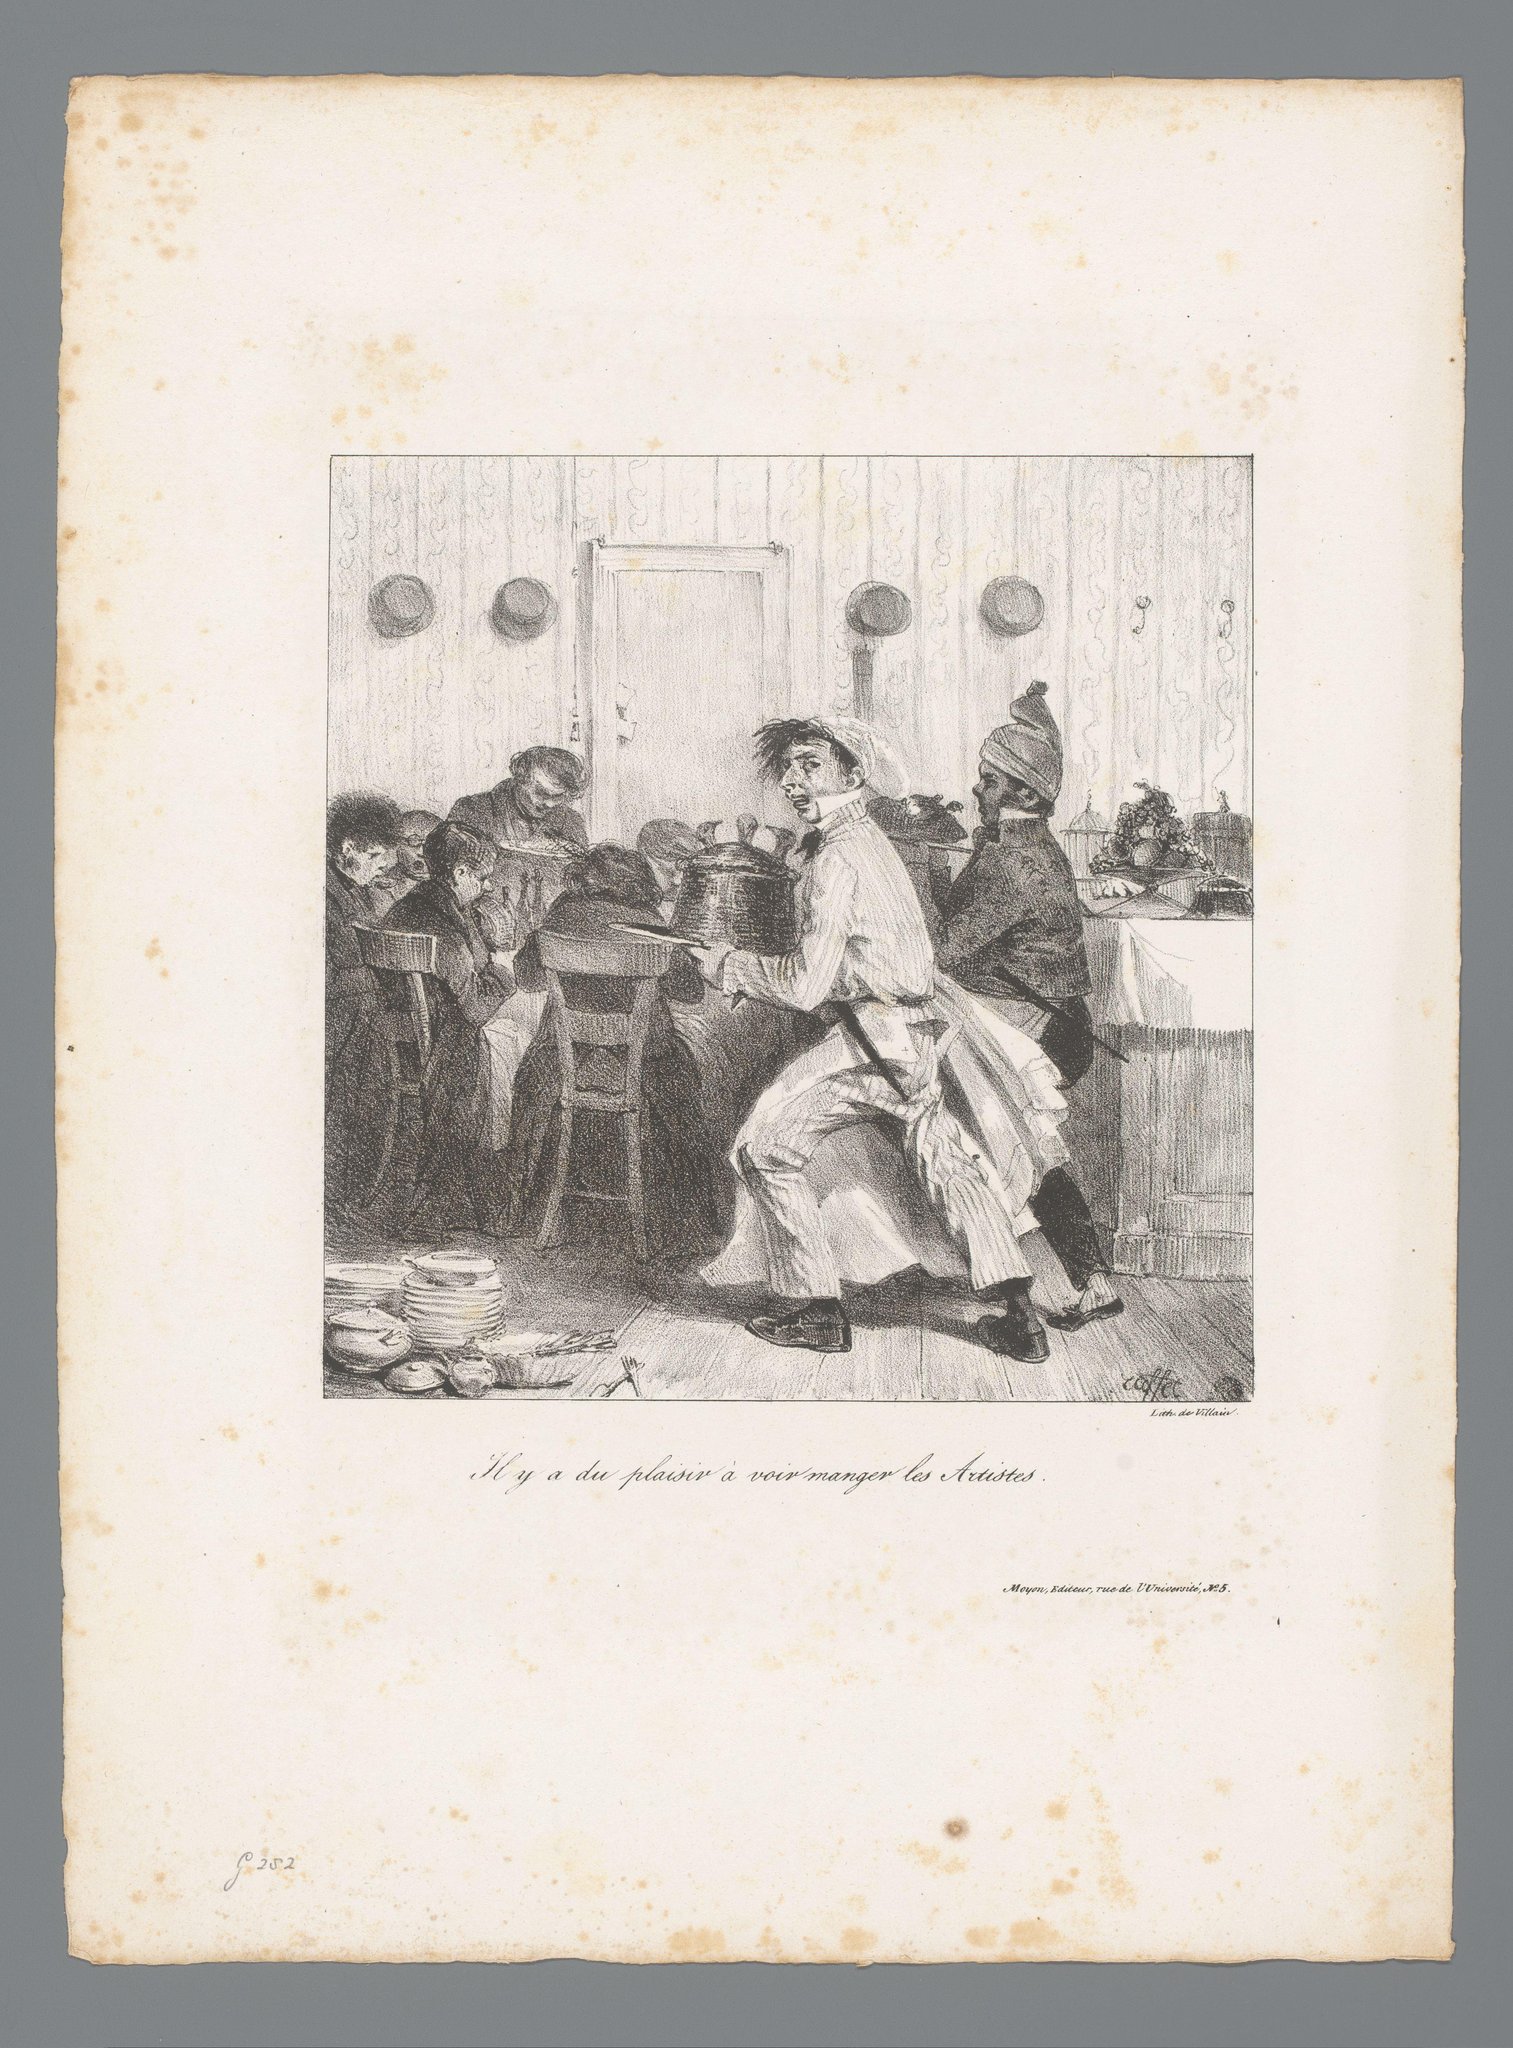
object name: print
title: Album met prenten van Auguste Raffet uit 1827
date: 1827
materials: paper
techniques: lithograph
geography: paris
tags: cook, dish, plate, saucer, restaurant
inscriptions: collector's mark: Lugt 964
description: Serie bestaat uit titelprent en tien prenten. Elfde prent in de serie van elf prenten.